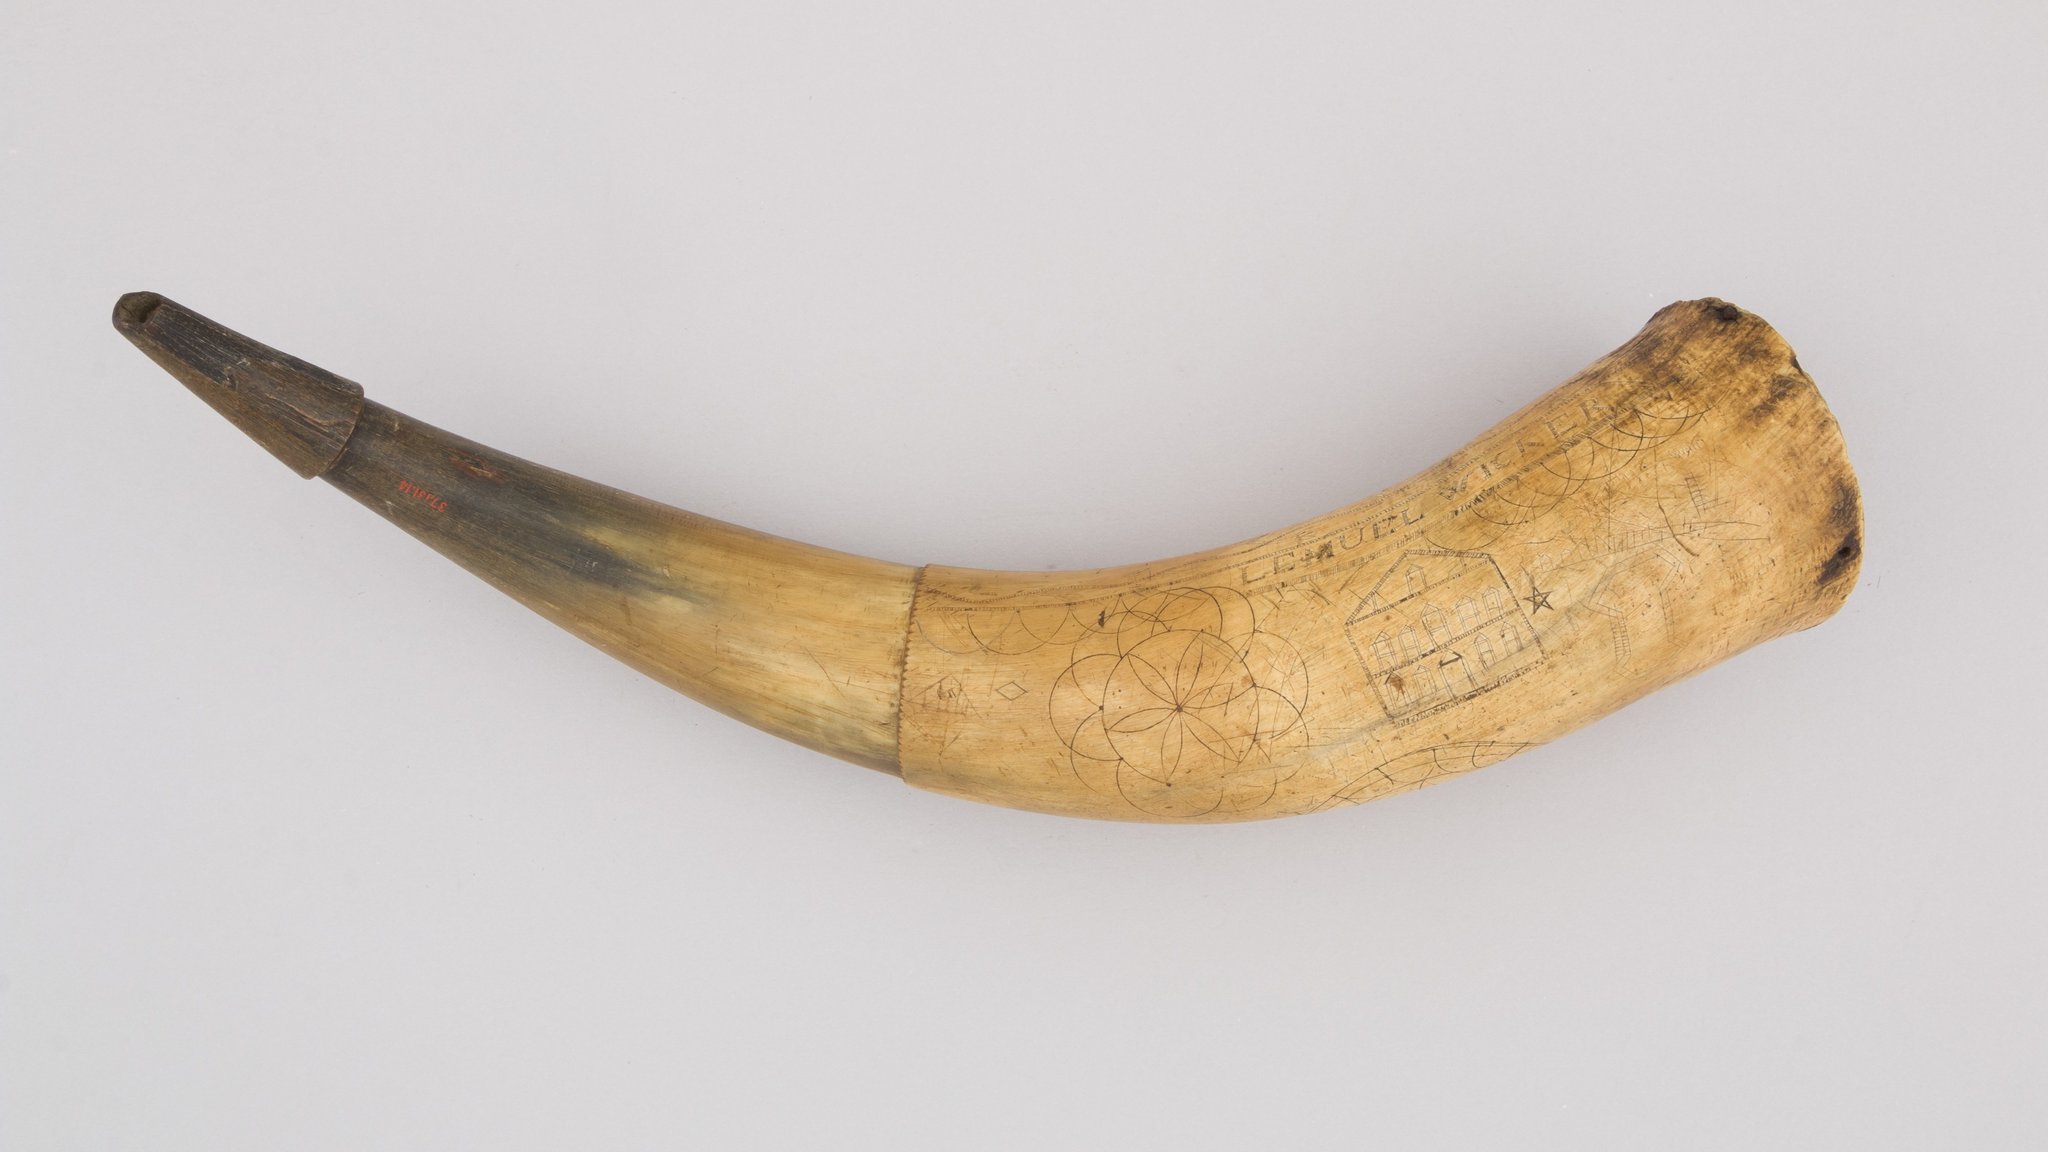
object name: powder horn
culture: colonial american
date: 1775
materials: horn, iron, wood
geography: united states